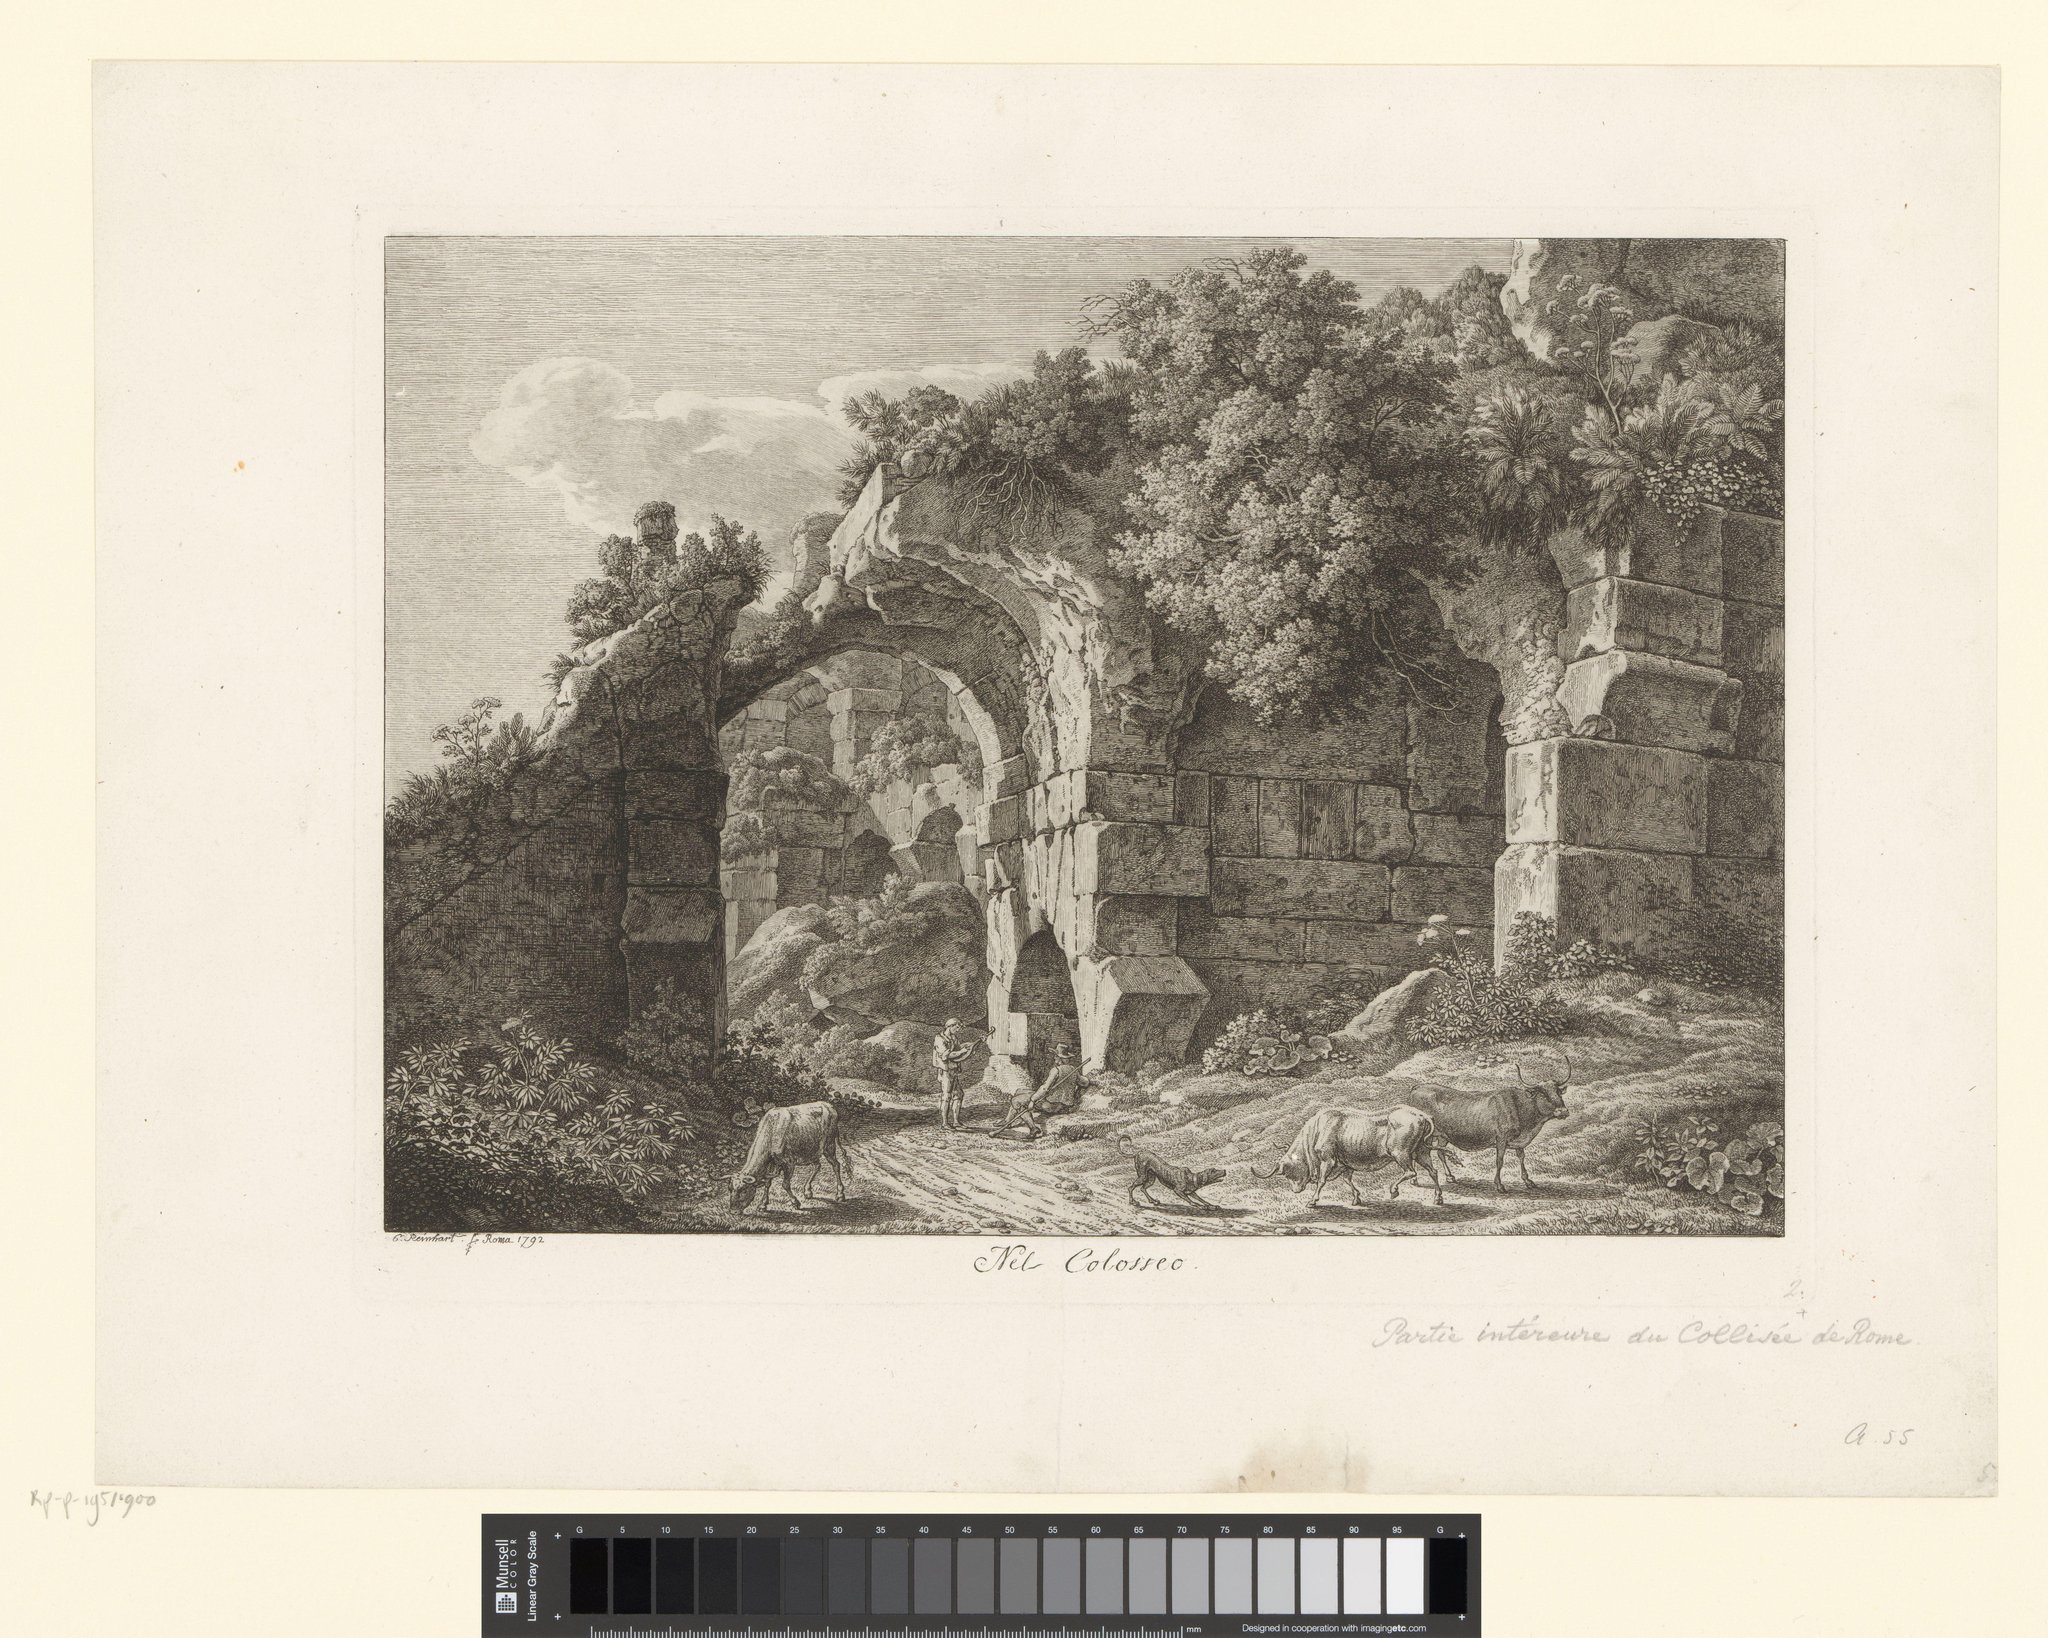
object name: print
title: Mahlerisch-radirte Prospecte von Italien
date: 1792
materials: paper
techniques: engraving, etching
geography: nuremberg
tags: landscapes, landscape with monument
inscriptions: : ‘Partie intérieur du Collisée de Rome’, collector's mark: Lugt 2228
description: Behorend tot een serie van 72 'Mahlerisch-radirte Prospecte von Italien', waarvoor de kunstenaar 24 prenten maakte. Albert Christoph Dies (1755-1822) en Jacob Wilhelm Mechau (1745-1808) maakten eveneens 24 platen, in opdracht van Jean Fréderic Frauenholz. Vanaf 1792 verschenen telkens drie sets van twee prenten per kunstenaar. In 1798 werd de laatste set uitgegeven, waarna complete sets gebonden werden uitgegeven tot in 1875 (Nuerenberg: J.L. Lotzbeck). Zie: Schmid, F.C., A.C. Dies, J.W. Mechau und J.C. Reinhart 'Mahlerische radirte Prospecte von Italien' (...). Berlijn: s.n., 1991.